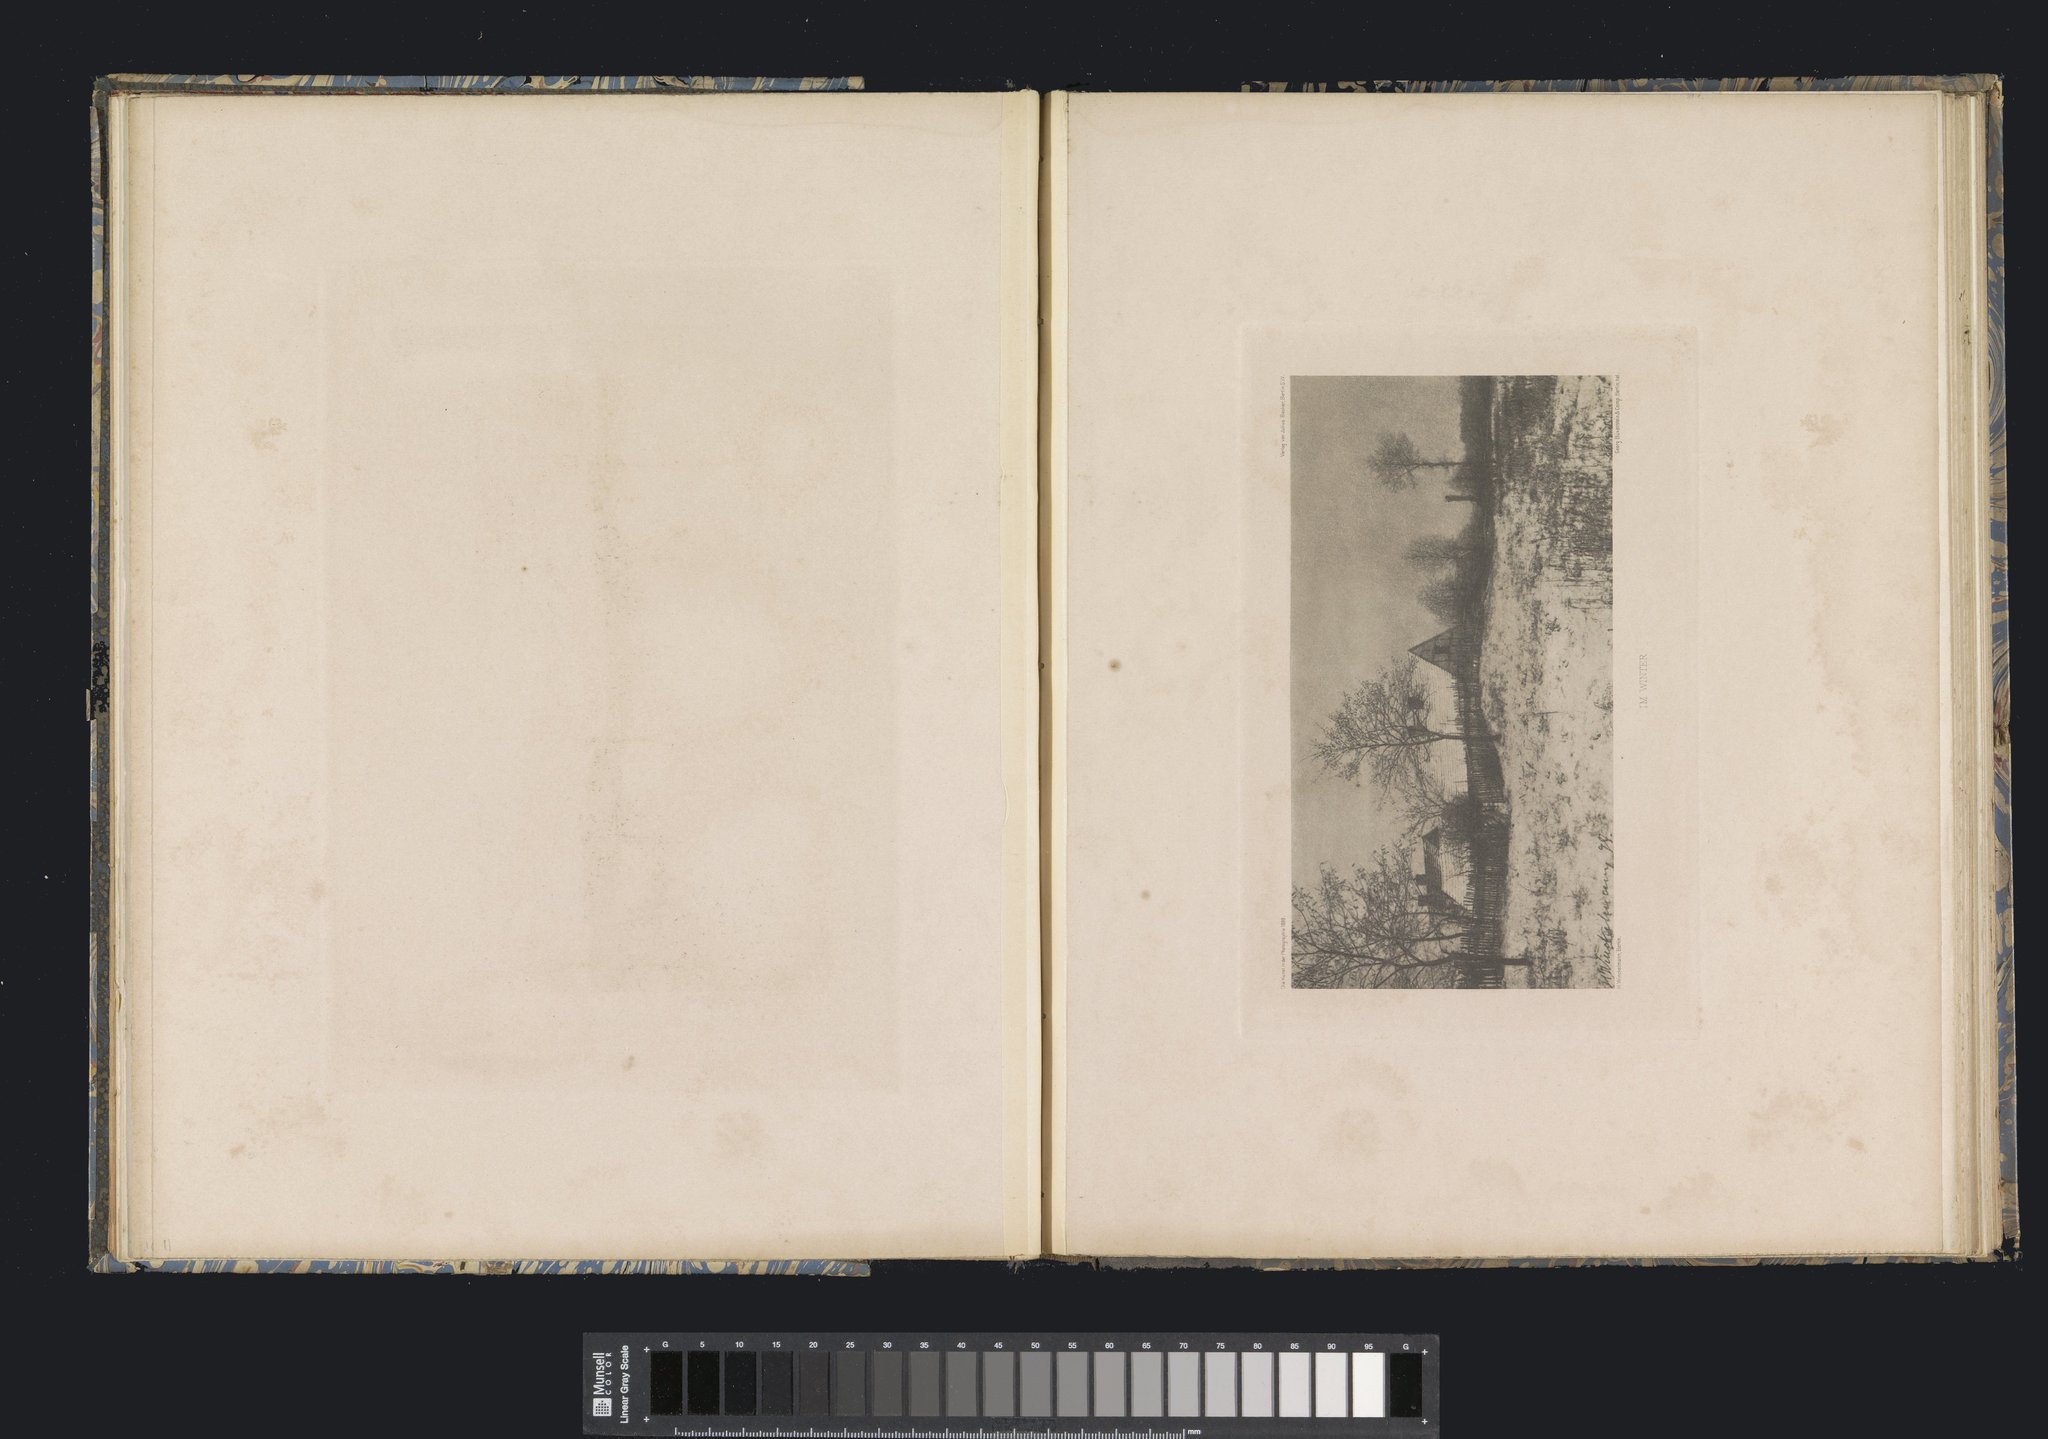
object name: photomechanical print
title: Gezicht op een huis in een besneeuwd landschap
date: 1889-1899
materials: paper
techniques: photoaquatint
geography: berlin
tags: winter landscape; landscape symbolizing winter (the four seasons of the year), façade (of house or building)